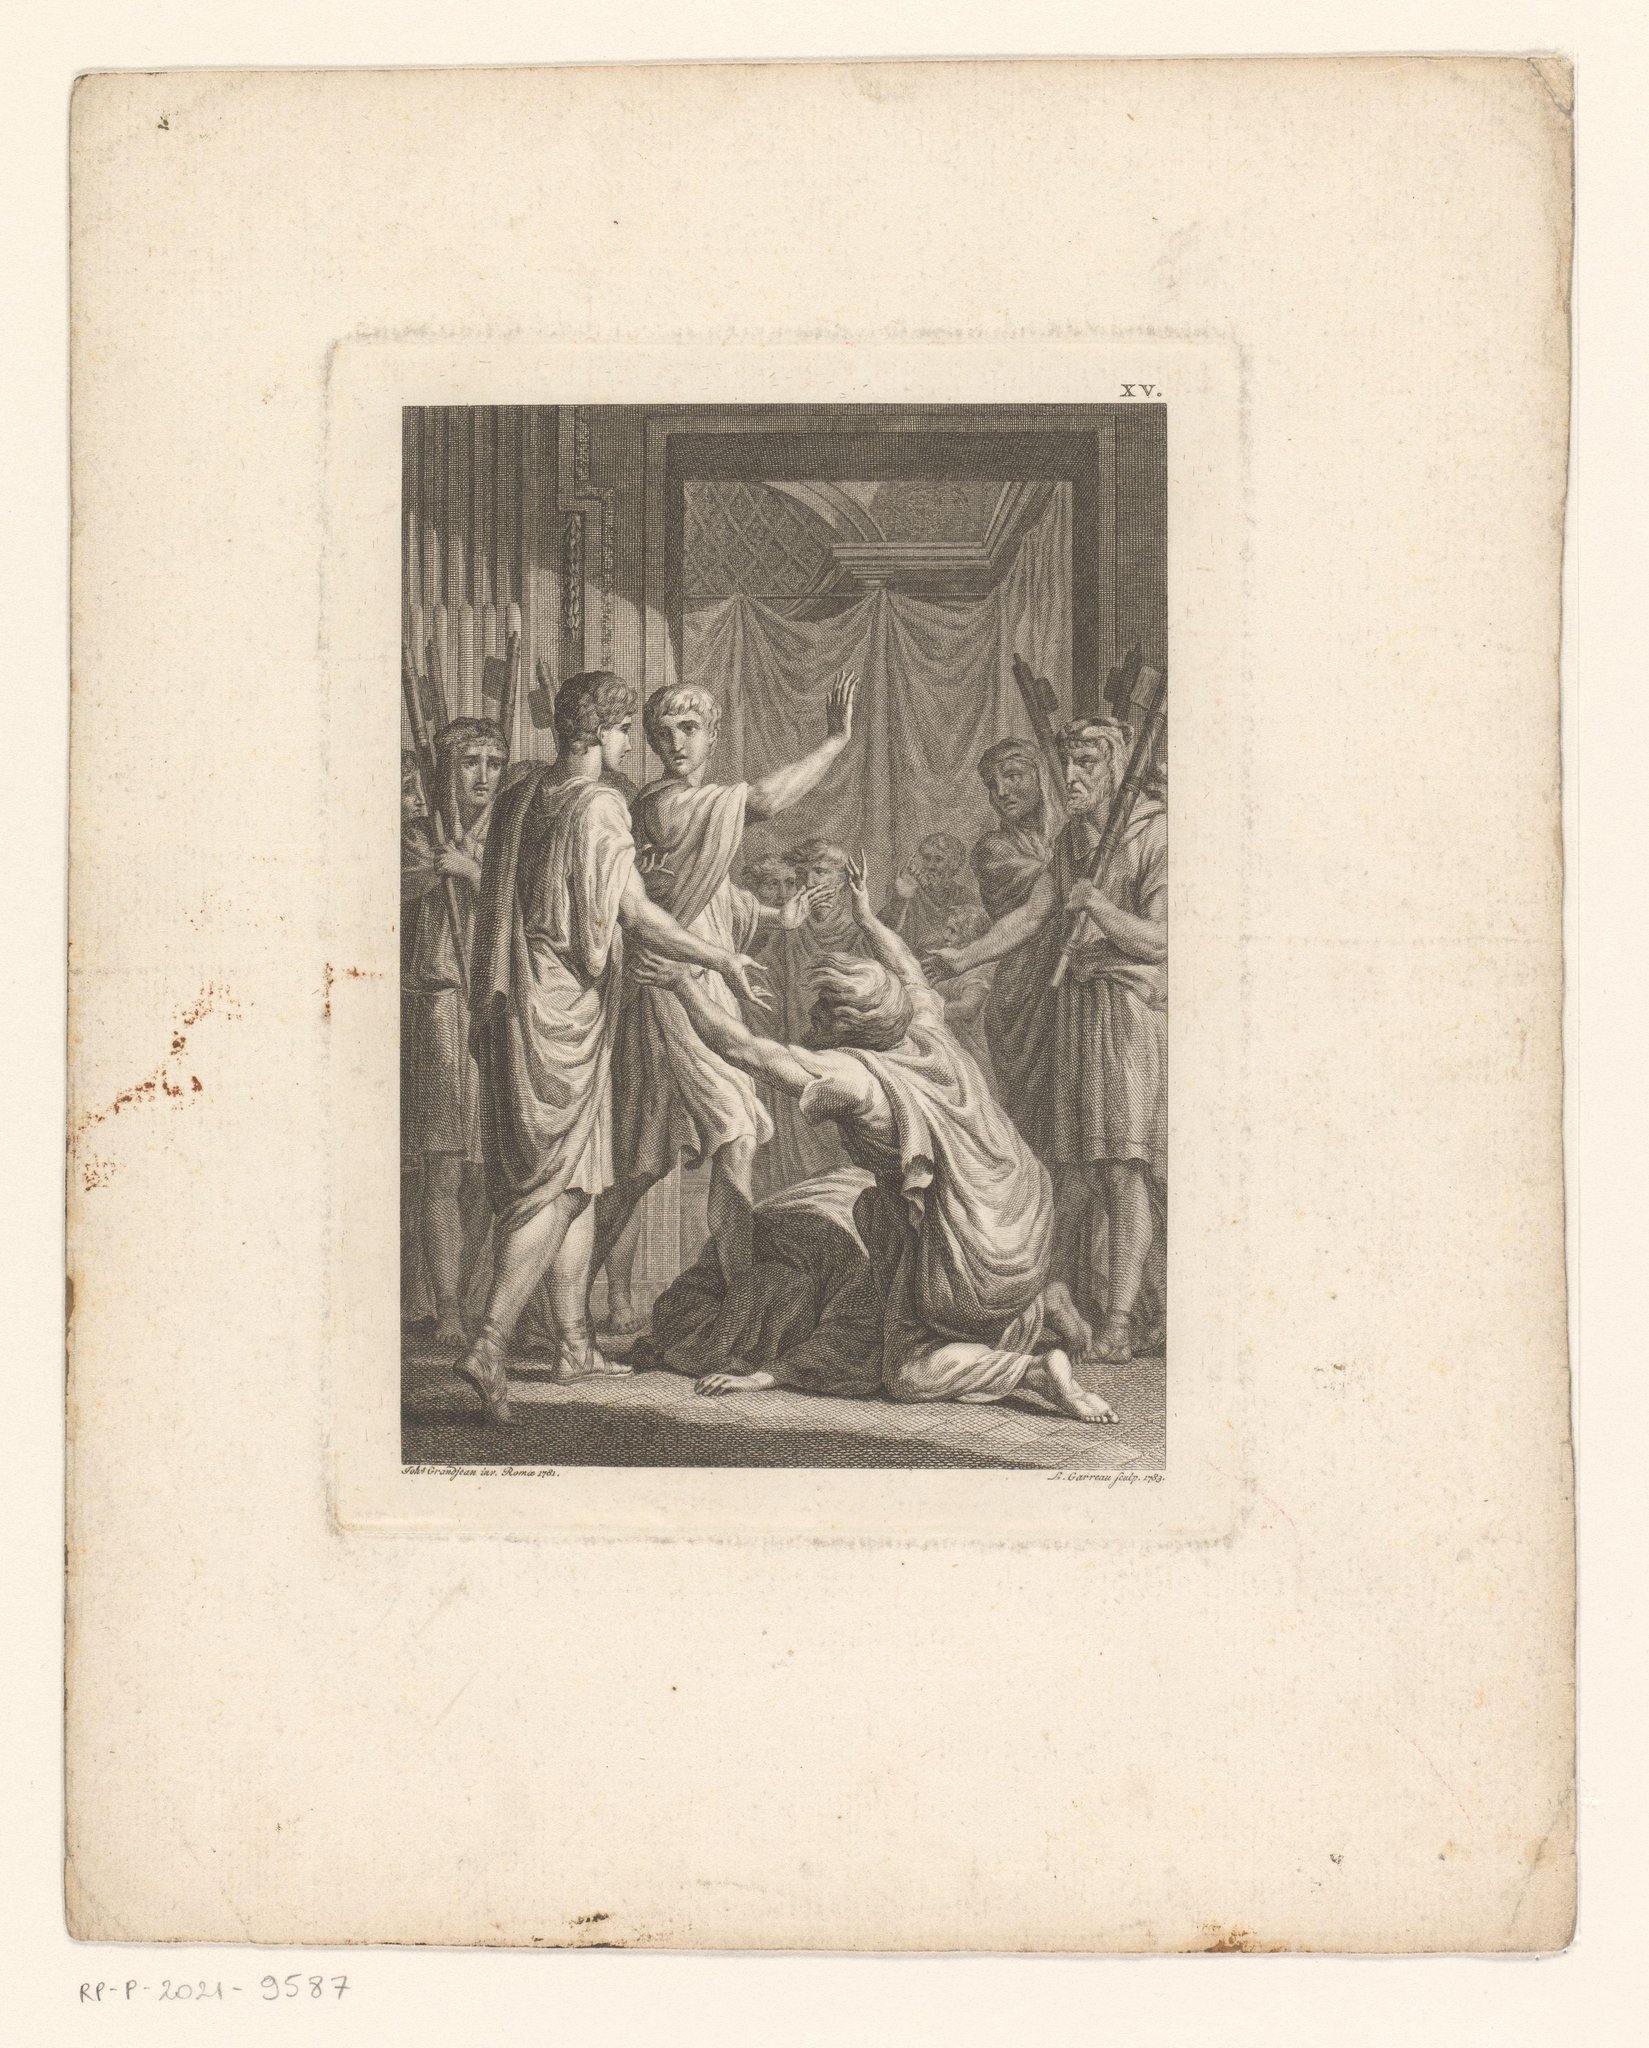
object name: print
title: Geschiedenis van Germanicus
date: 1783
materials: paper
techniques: engraving, etching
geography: rome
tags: father-love, (story of) germanicus, kneeling on both knees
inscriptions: date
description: Volgens Muller werden de prenten uit deze serie door verschillende prentmakers in 1783 gemaakt naar de kleine schilderijen van Grandjean te Rome, en in 1788 uitgegeven. De prent wordt ook ingebonden gevonden in: Winter, Lucretia Wilhelmina van. Germanicus in Zestien Boeken. Amsterdam: Pieter Meijer, 1779.